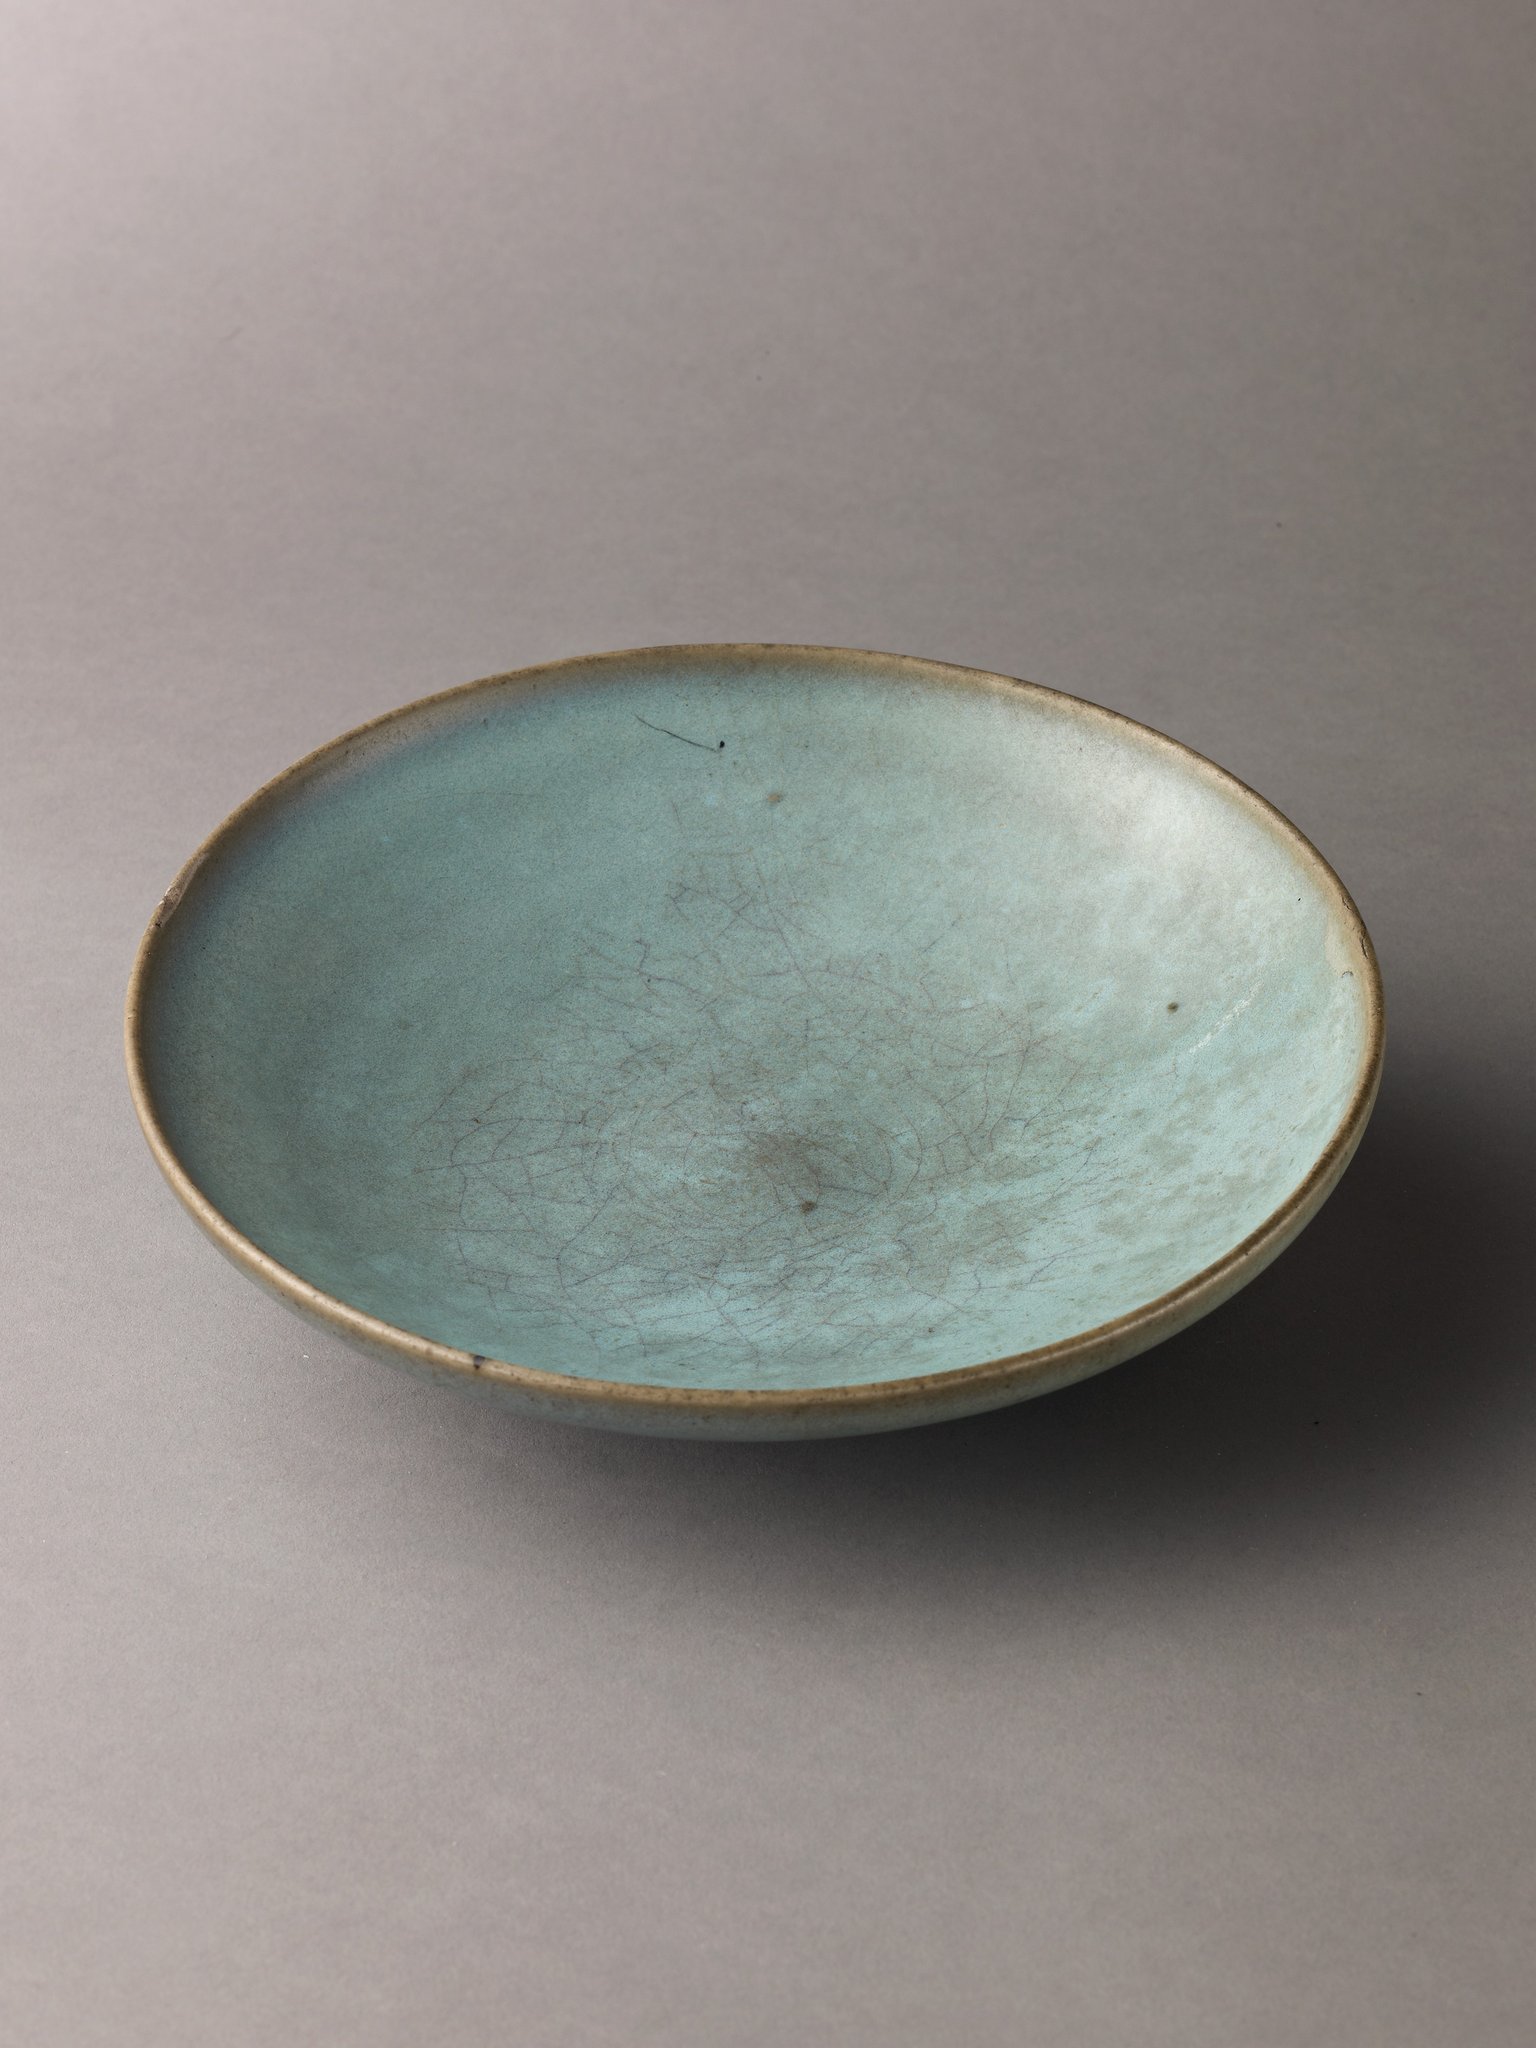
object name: dish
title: Shallow dish, Jun ware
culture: chinese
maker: chinese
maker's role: artist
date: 1001-1200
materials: glaze, stoneware